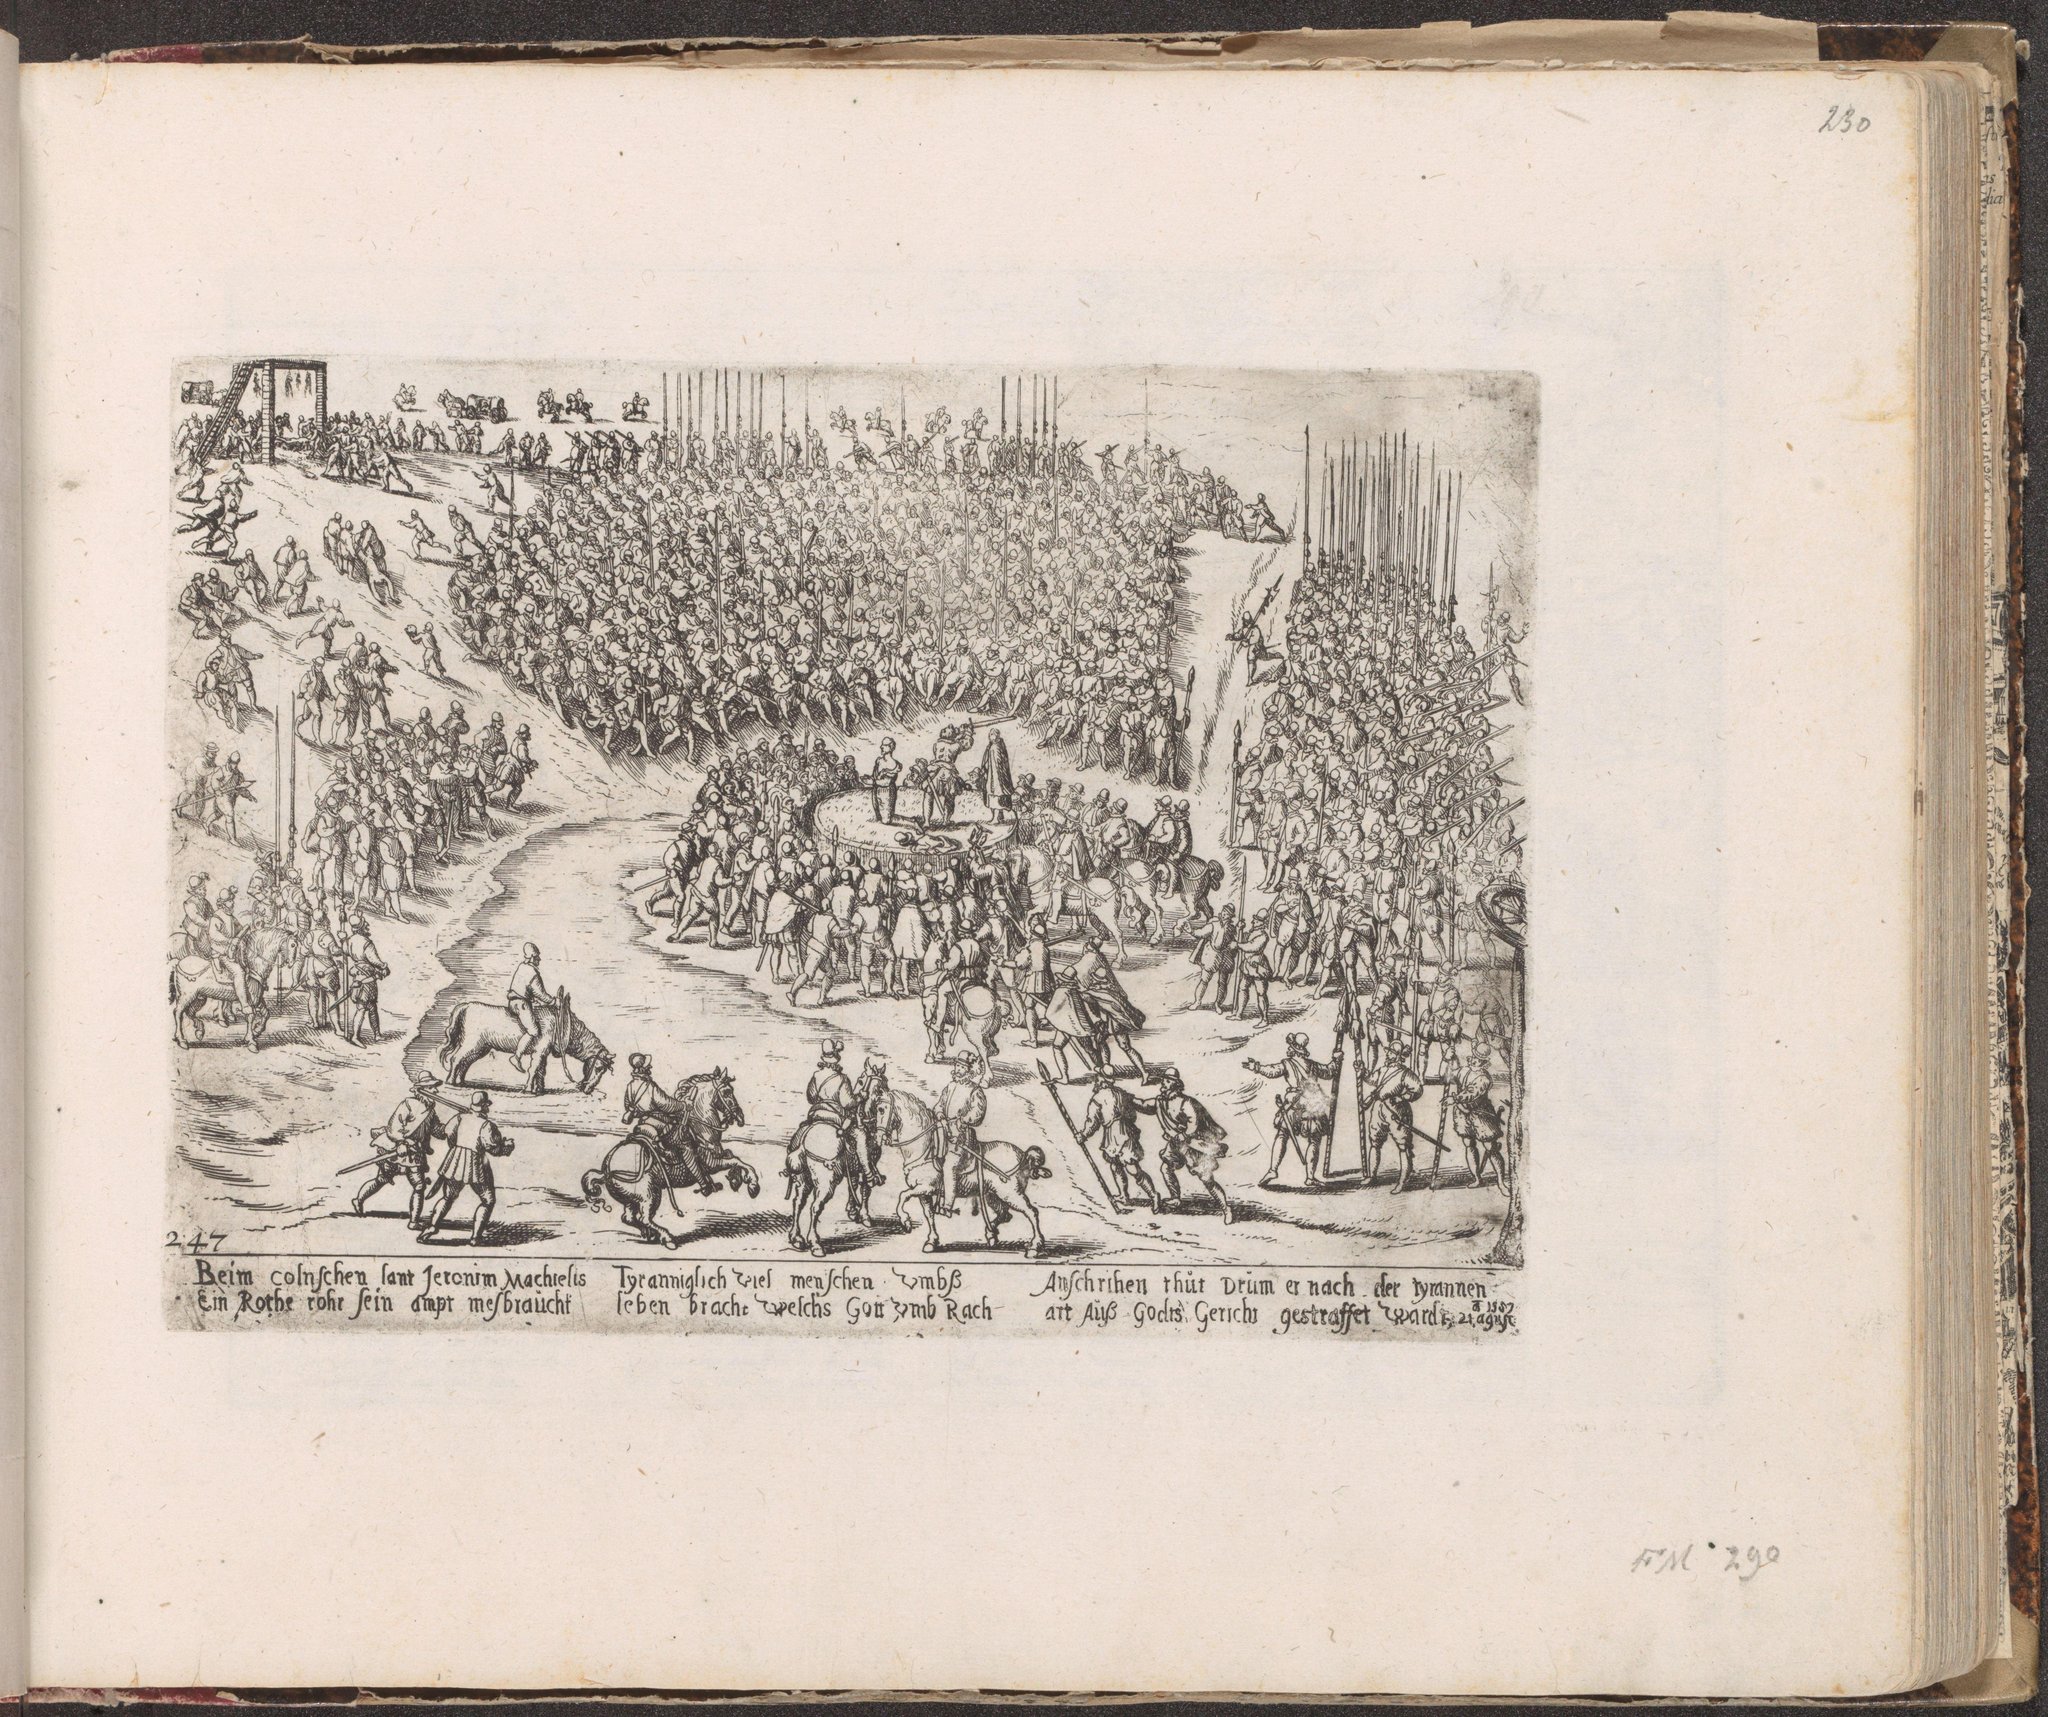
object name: print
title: Serie 10: Nederlandse en Buitenlandse Gebeurtenissen, 1587-1612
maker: frans hogenberg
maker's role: print maker, publisher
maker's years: 1538-1590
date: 1587-1591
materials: paper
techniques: etching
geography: cologne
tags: cologne, violent death by beheading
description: Executie van Hieronymus Michiels (Jeronim Machielis) in Keulen, 21 augustus 1587. Michiels knielt op het schavot om onthoofd te worden. Hieromheen een grote groep soldaten en ander toeschouwers. Met onderschrift van 6 regels in het Duits. Genummerd: 247. De prent maakt deel uit van een album.